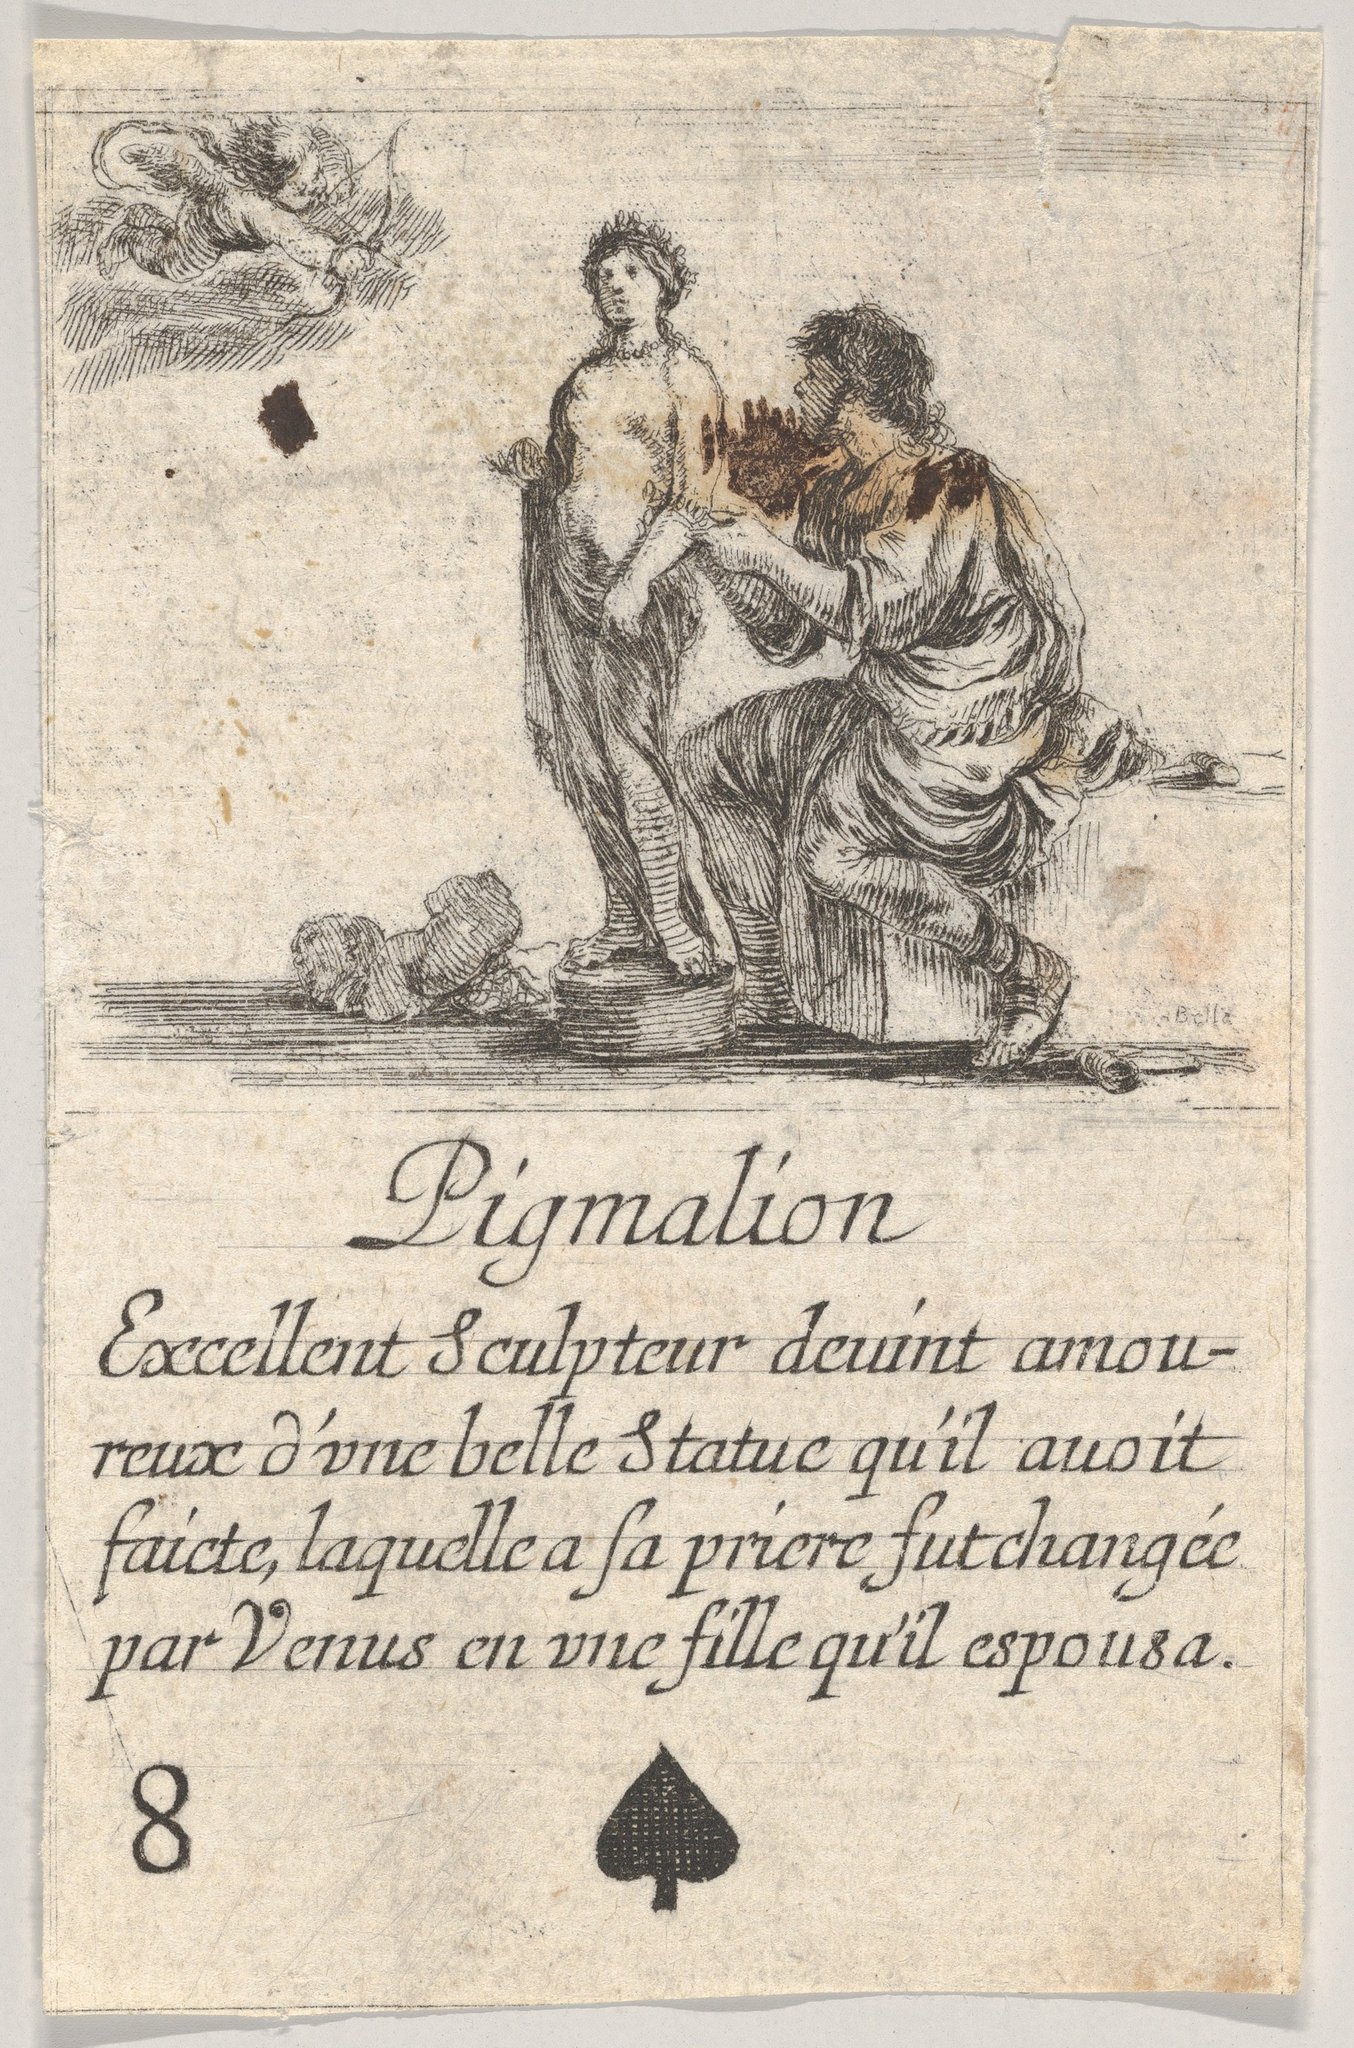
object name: print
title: Pygmalion, from "Game of Mythology" (Jeu de la Mythologie)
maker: stefano della bella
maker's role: artist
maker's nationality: italian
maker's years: 1610-1664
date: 1644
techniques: etching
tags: women,pygmalion,putti